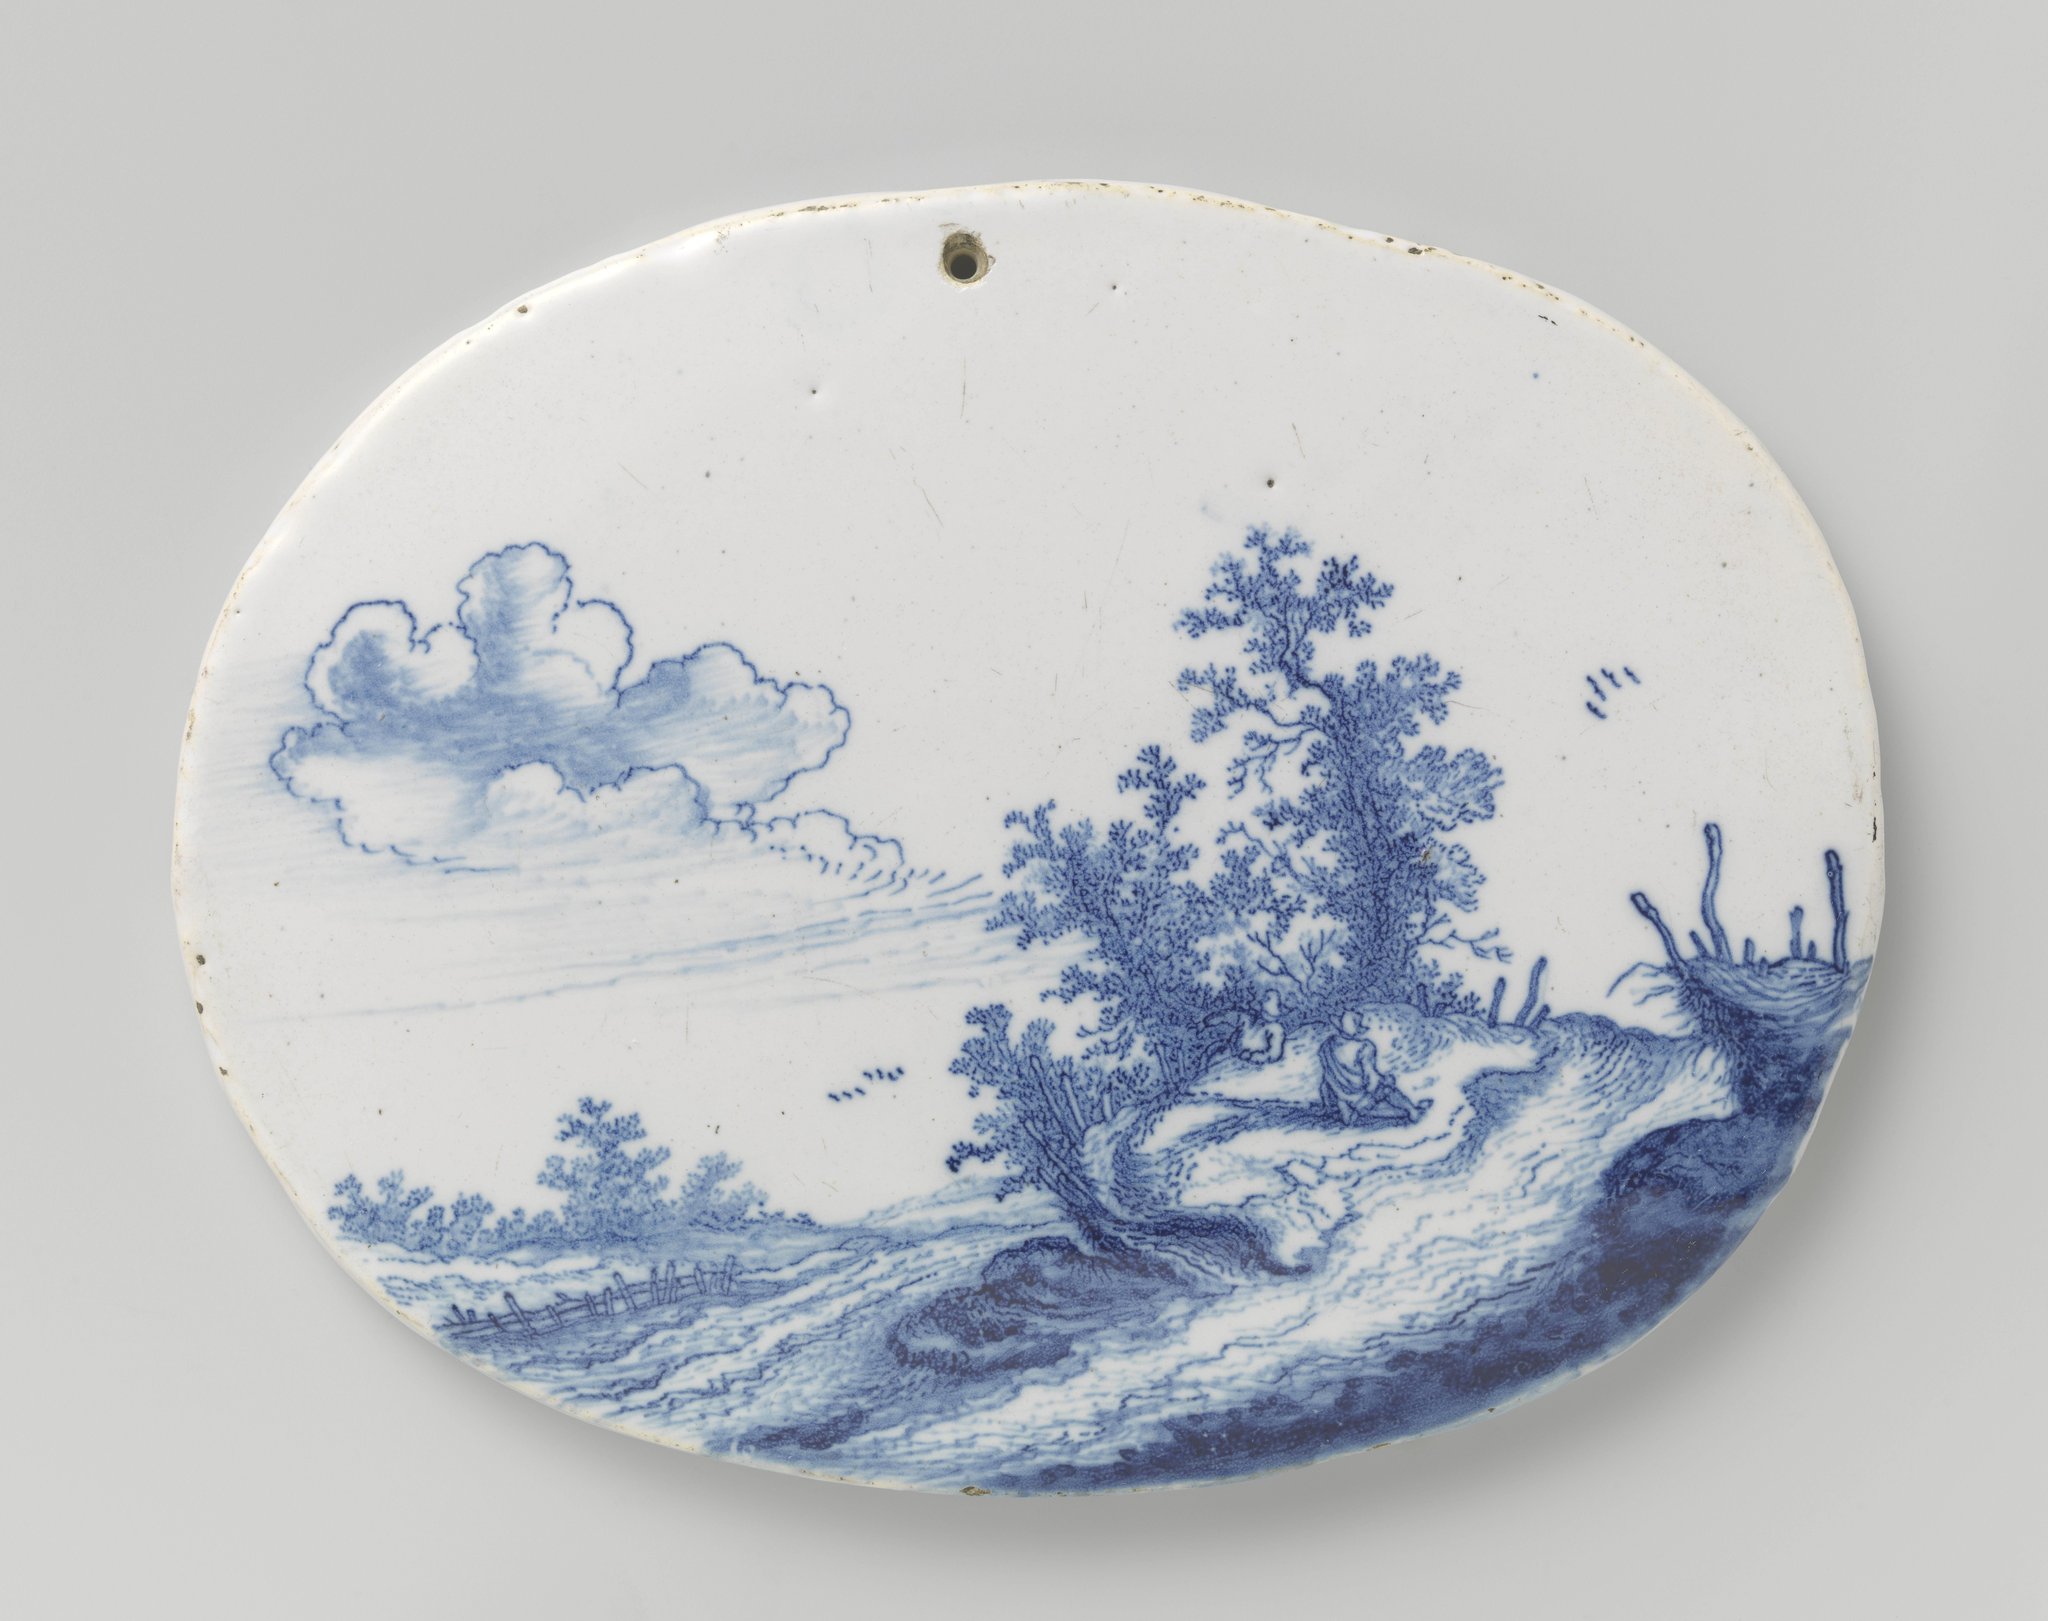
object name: plate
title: Oval Plaque with Landscape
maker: Anonymous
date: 1650-1665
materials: earthenware, glaze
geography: delft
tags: landscapes in the temperate zone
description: Ovale plaat van faïence, beschilderd met een landschap.